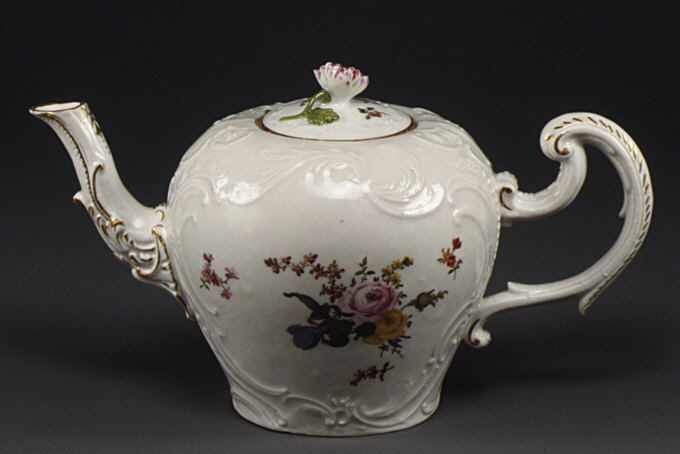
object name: teapot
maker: meissen manufactory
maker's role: manufactory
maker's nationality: german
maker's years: 1710-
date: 1750-1760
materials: hard paste porcelain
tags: roses